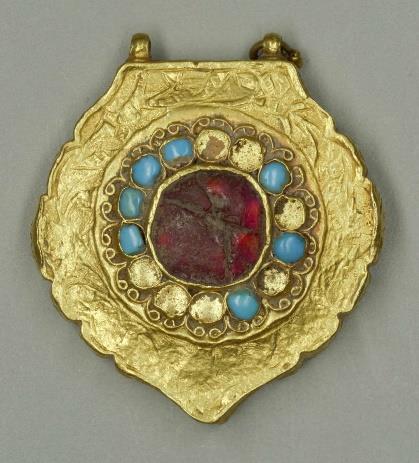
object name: pendant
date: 1767-1800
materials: glass, gold, stone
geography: turkey